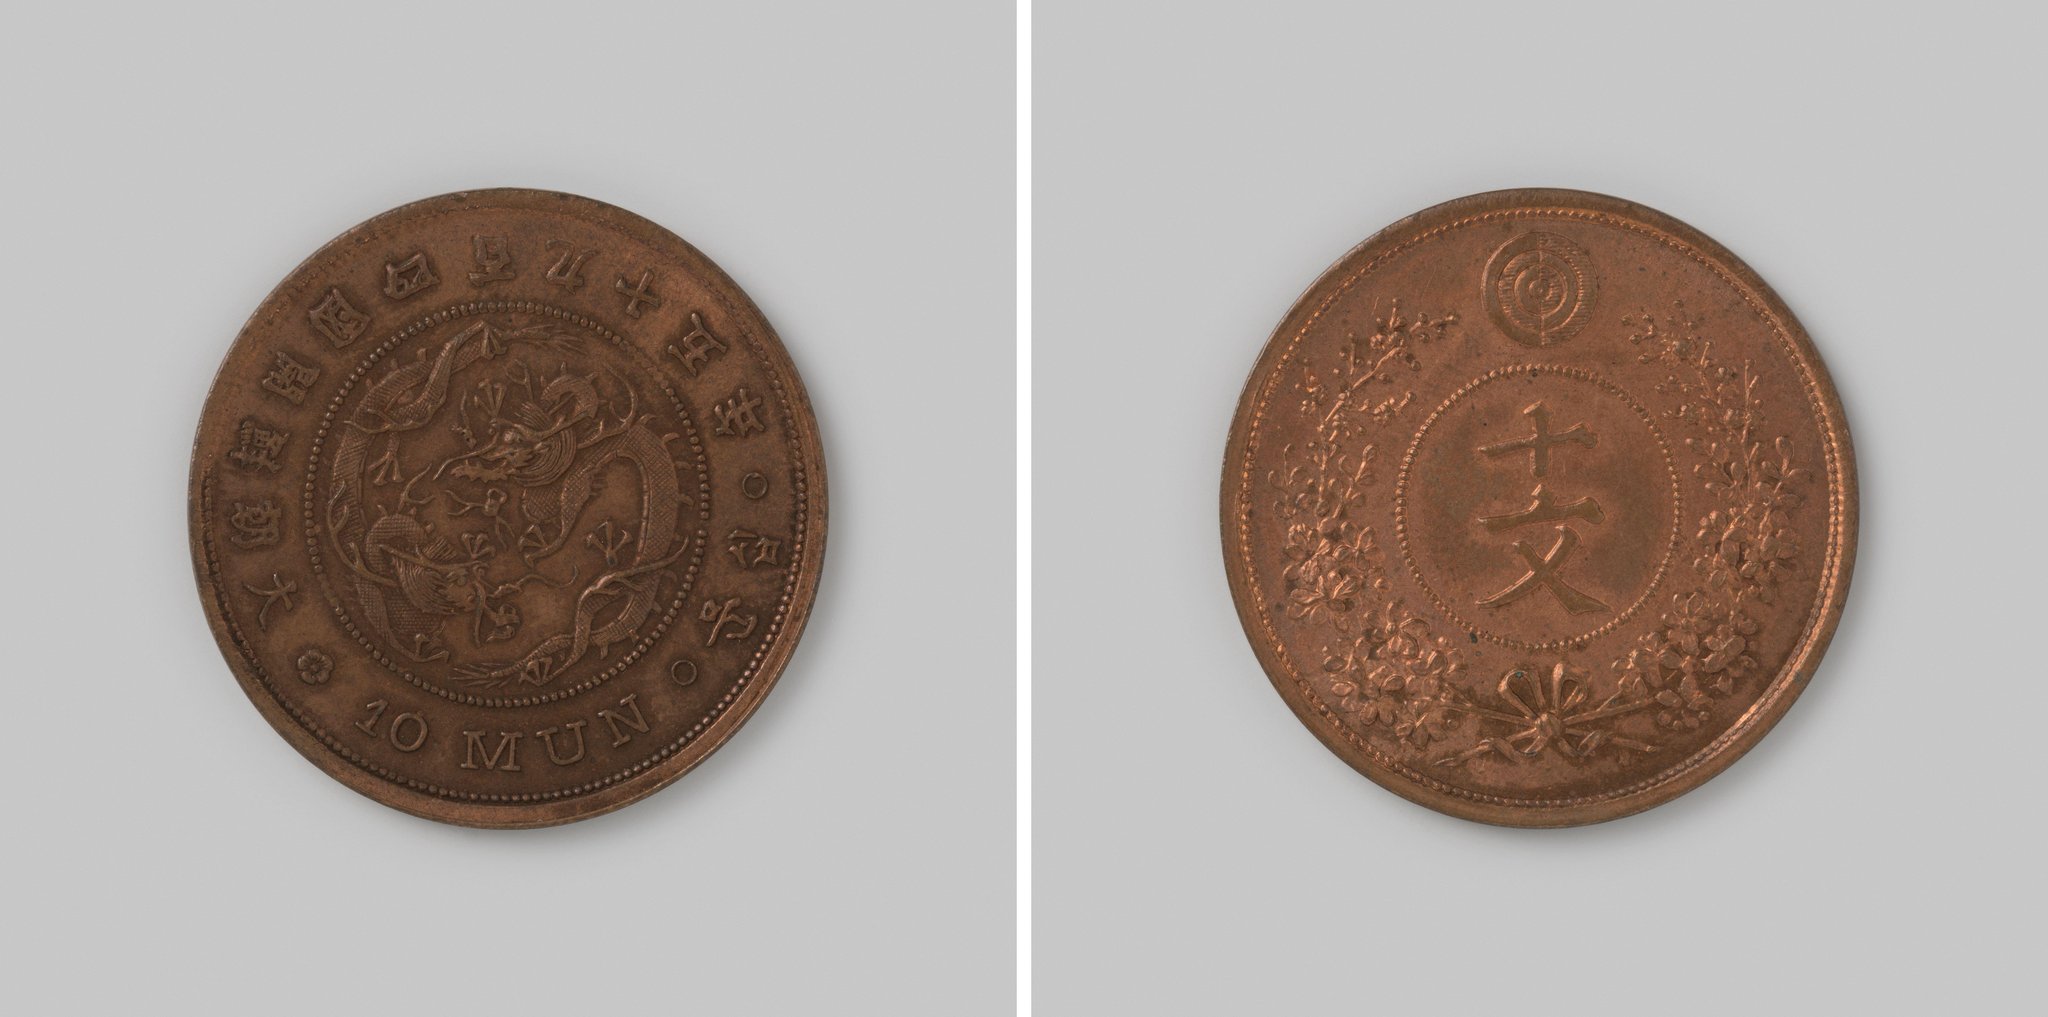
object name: coin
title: Koninkrijk Korea, 10 mun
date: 1888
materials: copper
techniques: striking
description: Koperen munt. Voorzijde: twee naar elkaar toegewende draken. In omschrift boven jaartal in Koreaanse telling: 497 [=1888] en onderaan waarde-aanduiding. Keerzijde: binnen twee samengeboden takken op twee regels waarde-aanduiding: + [= 10] en het Chinese teken voor mun. Gladde rand.